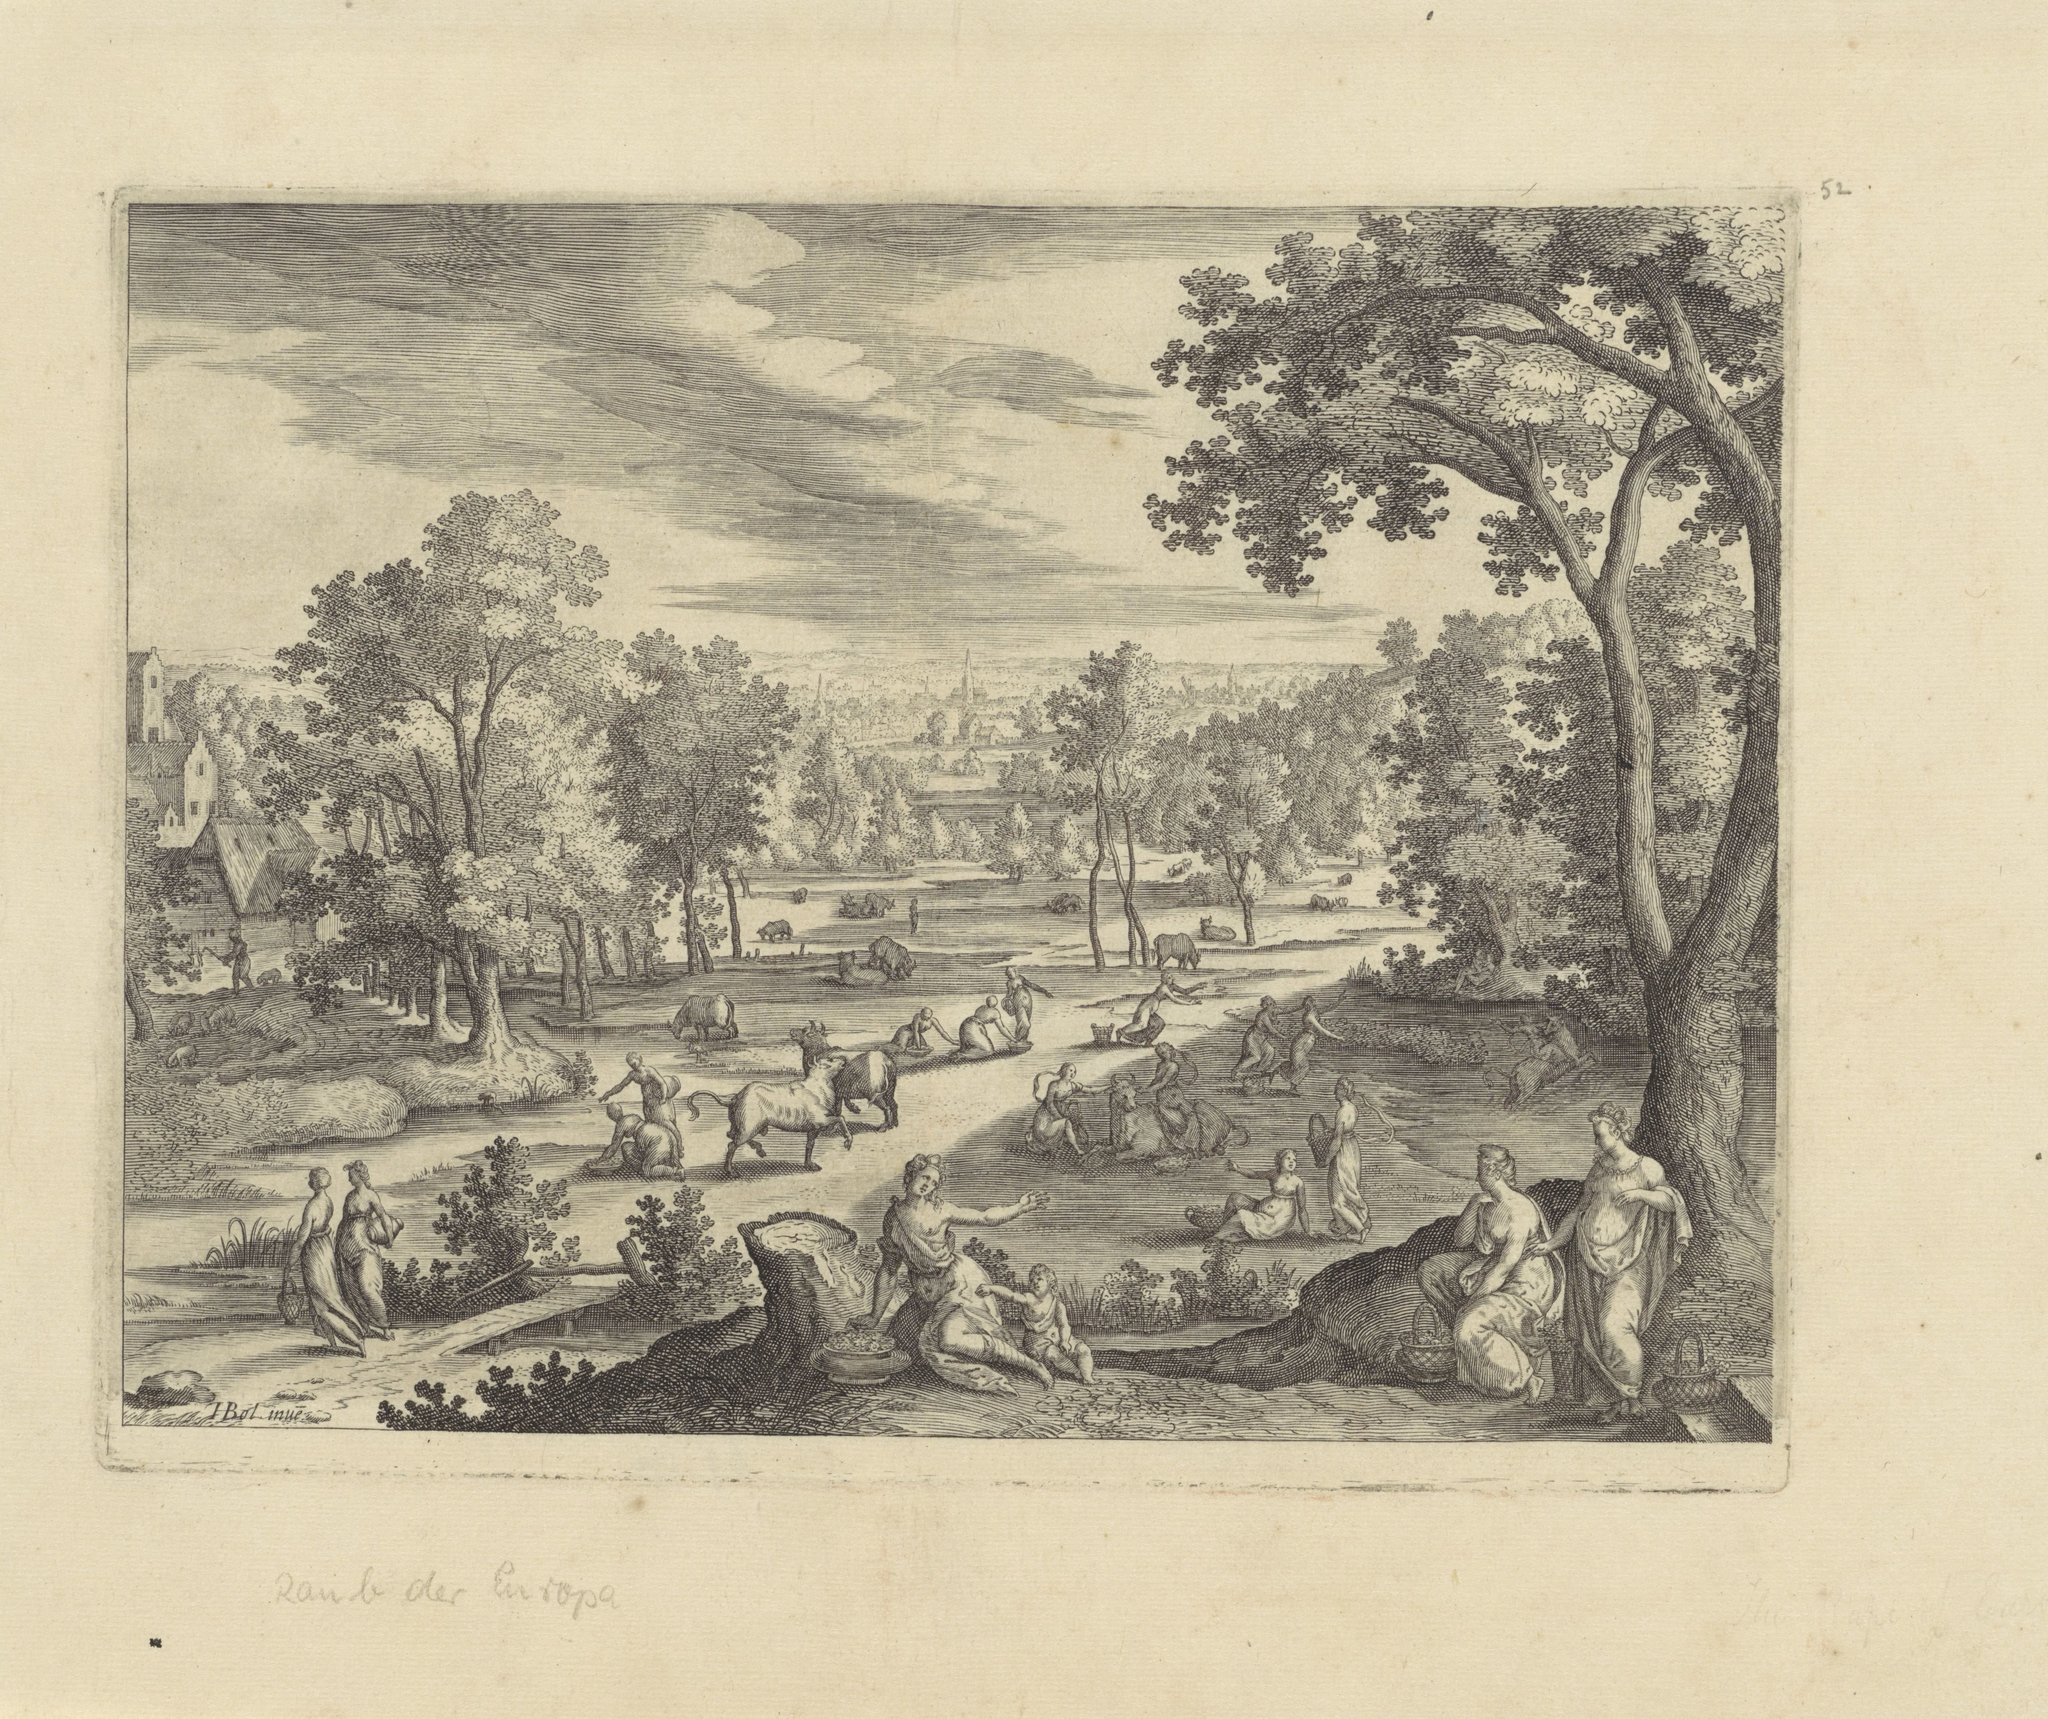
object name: print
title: Landschappen met verhalen uit Ovidius' Metamorphosen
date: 1550-1643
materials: paper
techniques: engraving, etching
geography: low countries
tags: jupiter, usually in the shape of a white bull, abducts europa and carries her across the water, europa and her maidens play with the bull, and/or adorn it with flowers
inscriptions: collector's mark: Lugt 2760, collector's mark: Lugt 2228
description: Jupiter bezoekt Europa in de gedaante van een witte stier. Europa zit op zijn rug en versiert zijn horens met bloemen. Ze wordt hierbij geholpen door één van haar dienstmaagden. De vrouwen worden omringd door nog meer dienstmaagden en koeien of stieren. Rechts ontvoert Jupiter Europa.